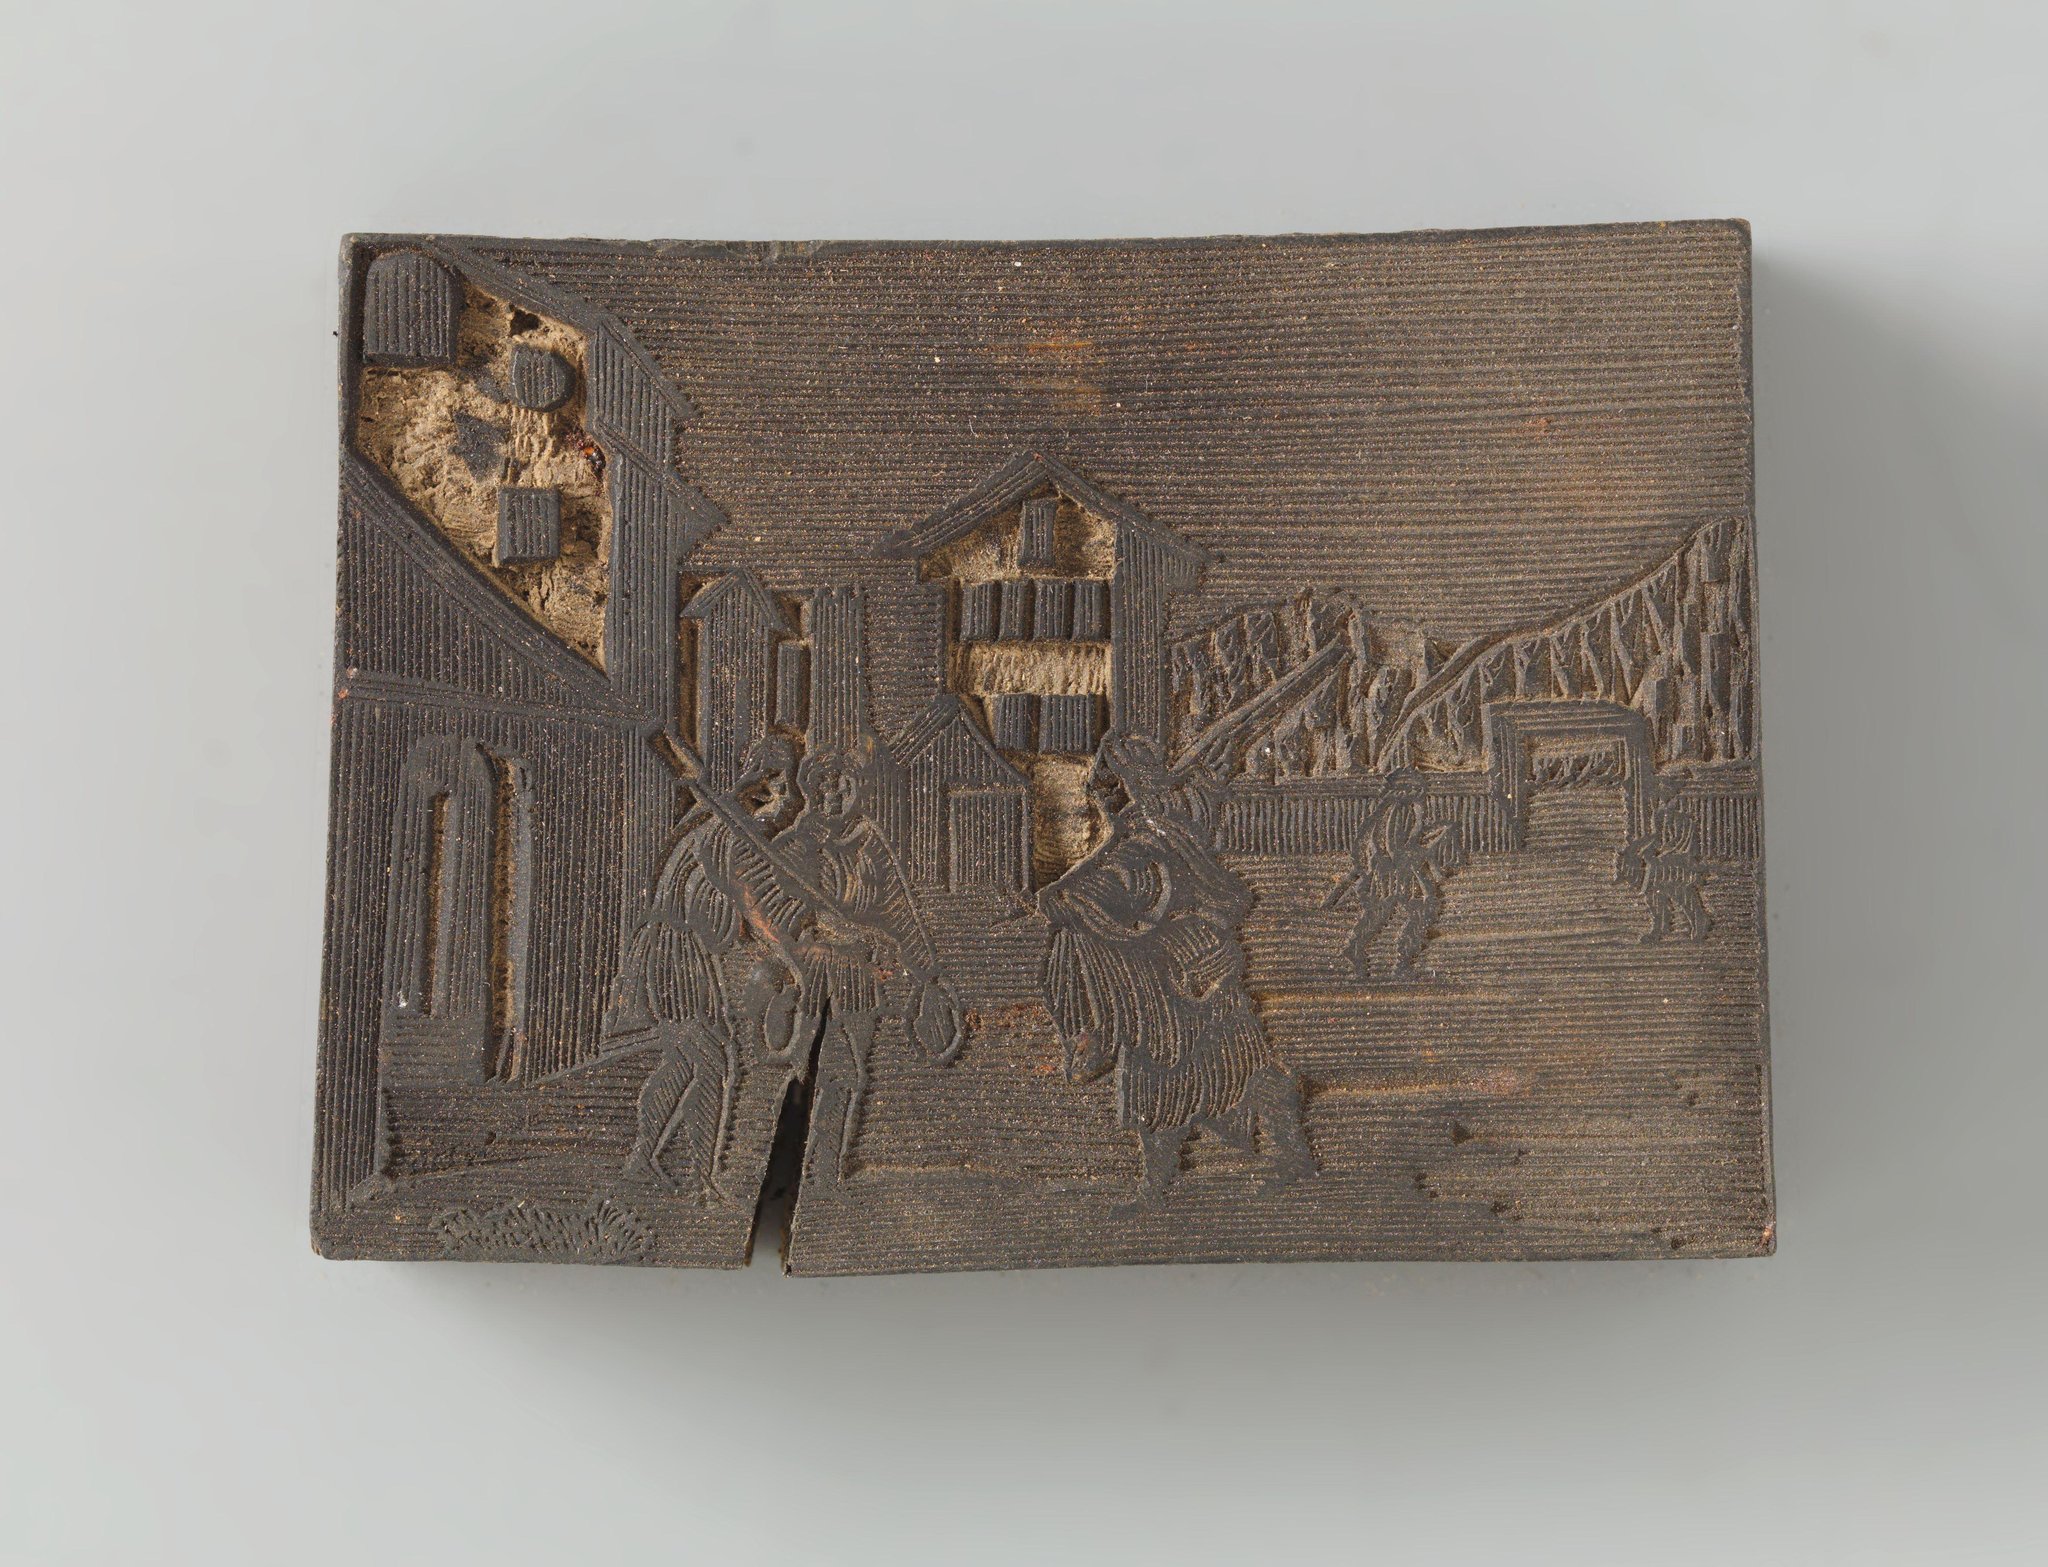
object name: wood block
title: Bijbel-illustraties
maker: Anonymous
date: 1550-1699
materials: wood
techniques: woodcut